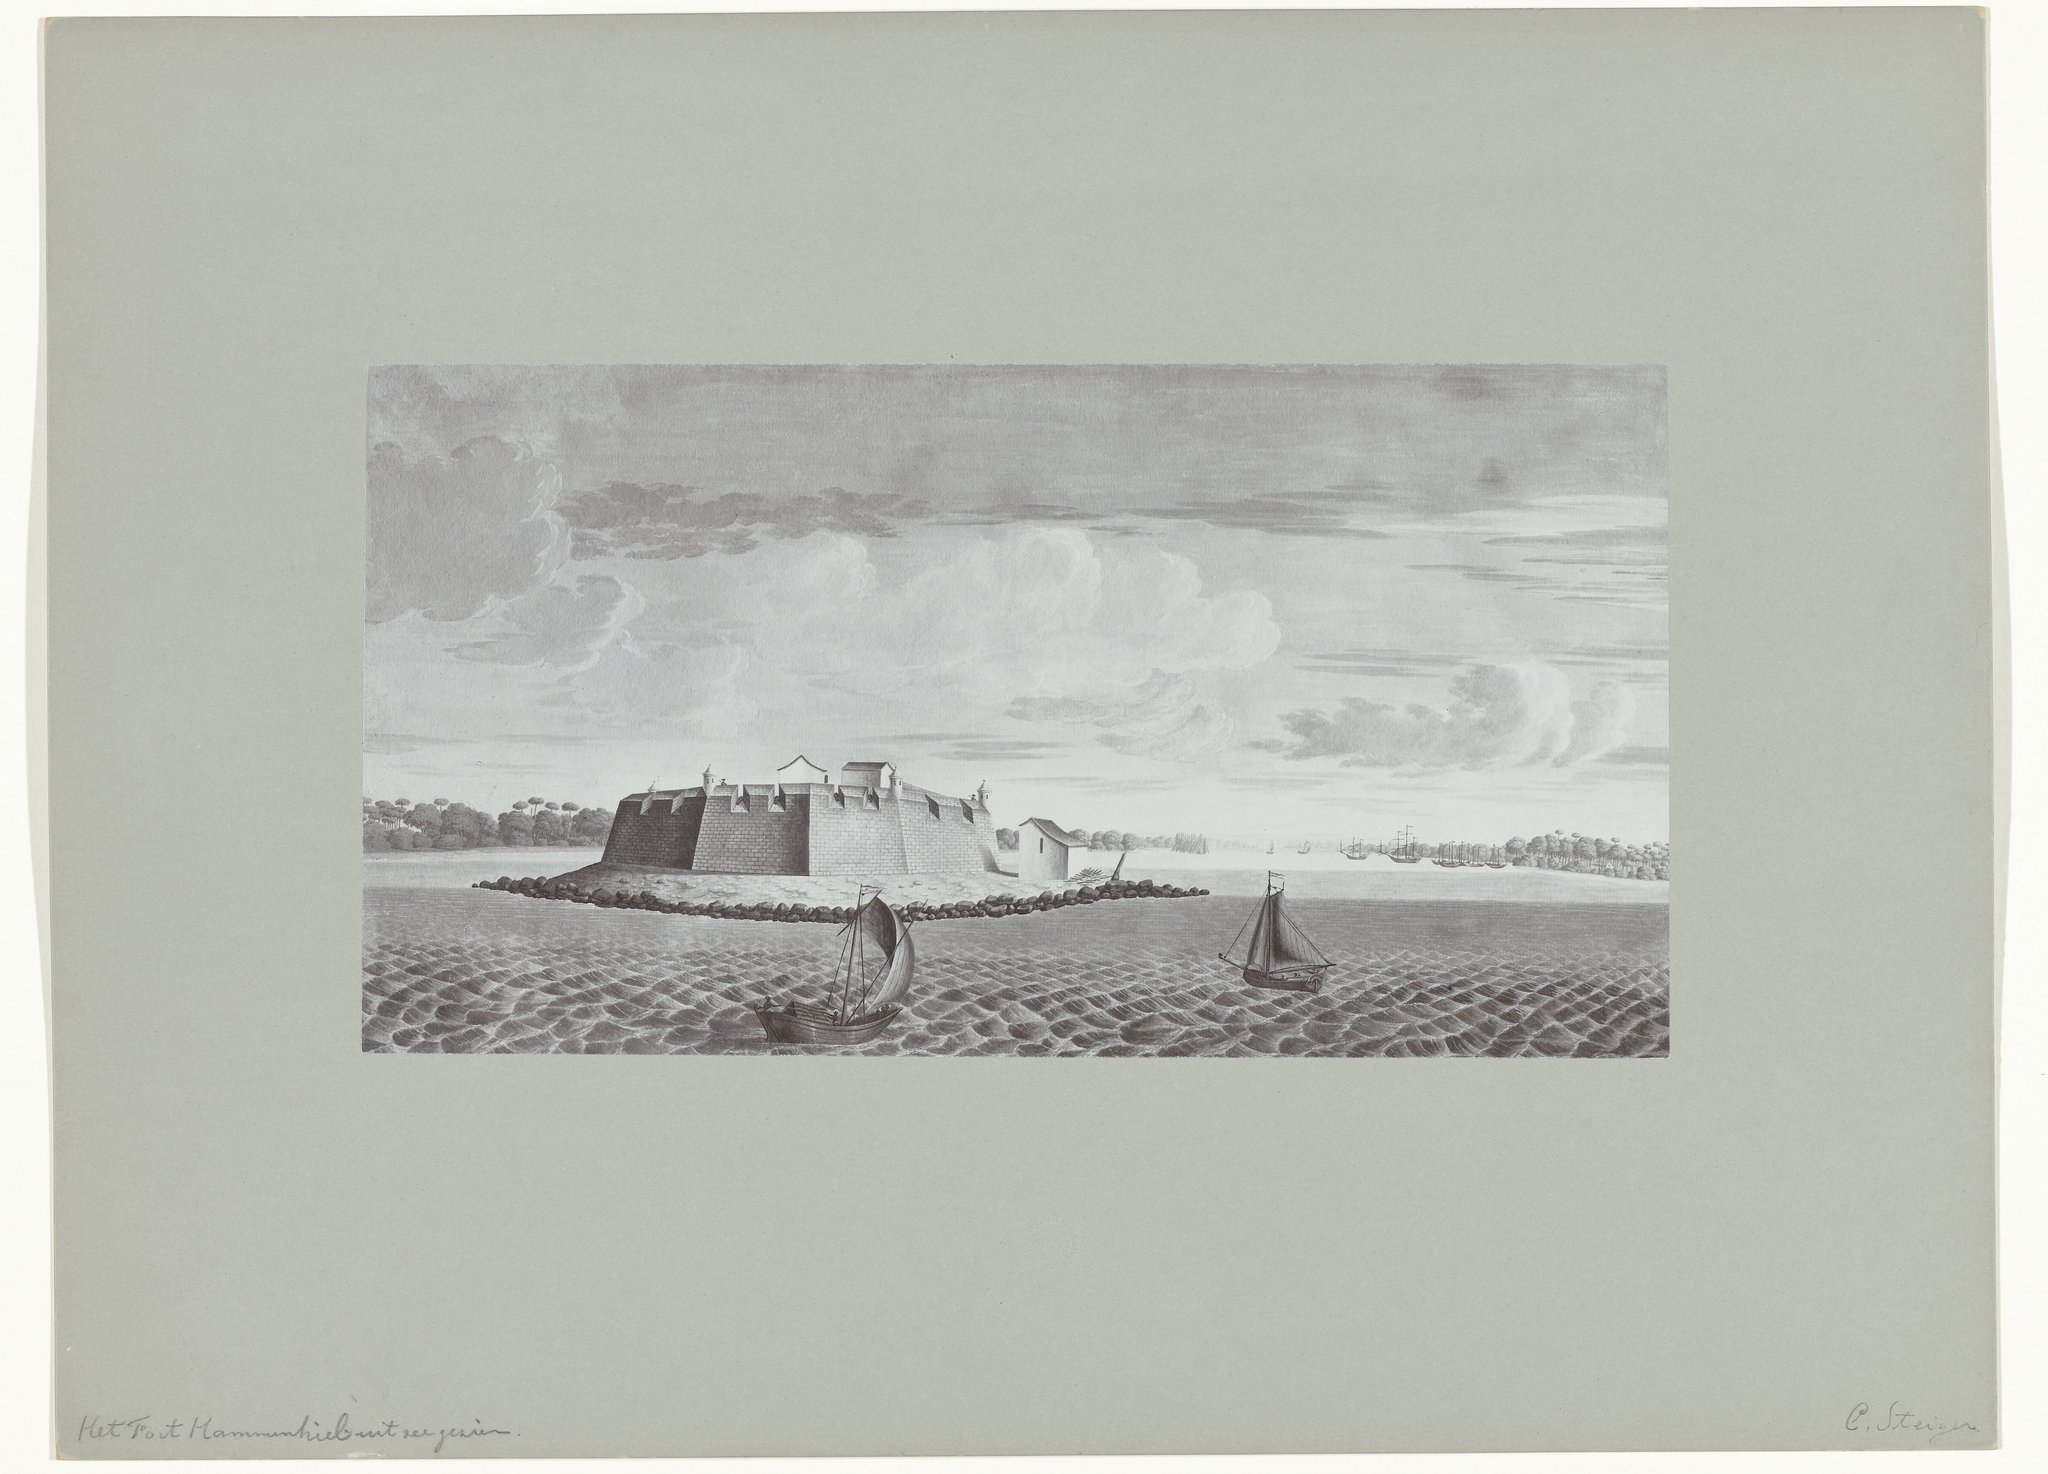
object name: photograph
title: Het Fort Hammenhiel vanuit zee gezien door C. Steiger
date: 1890-1910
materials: cardboard, paper, photographic support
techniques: collodion silver print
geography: amsterdam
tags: drawing, sketch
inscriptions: title: ‘Het Fort Hammenhiel vanuit zee gezien’, check stamp: ‘Roeloffzen, Hübner & Van Santen’